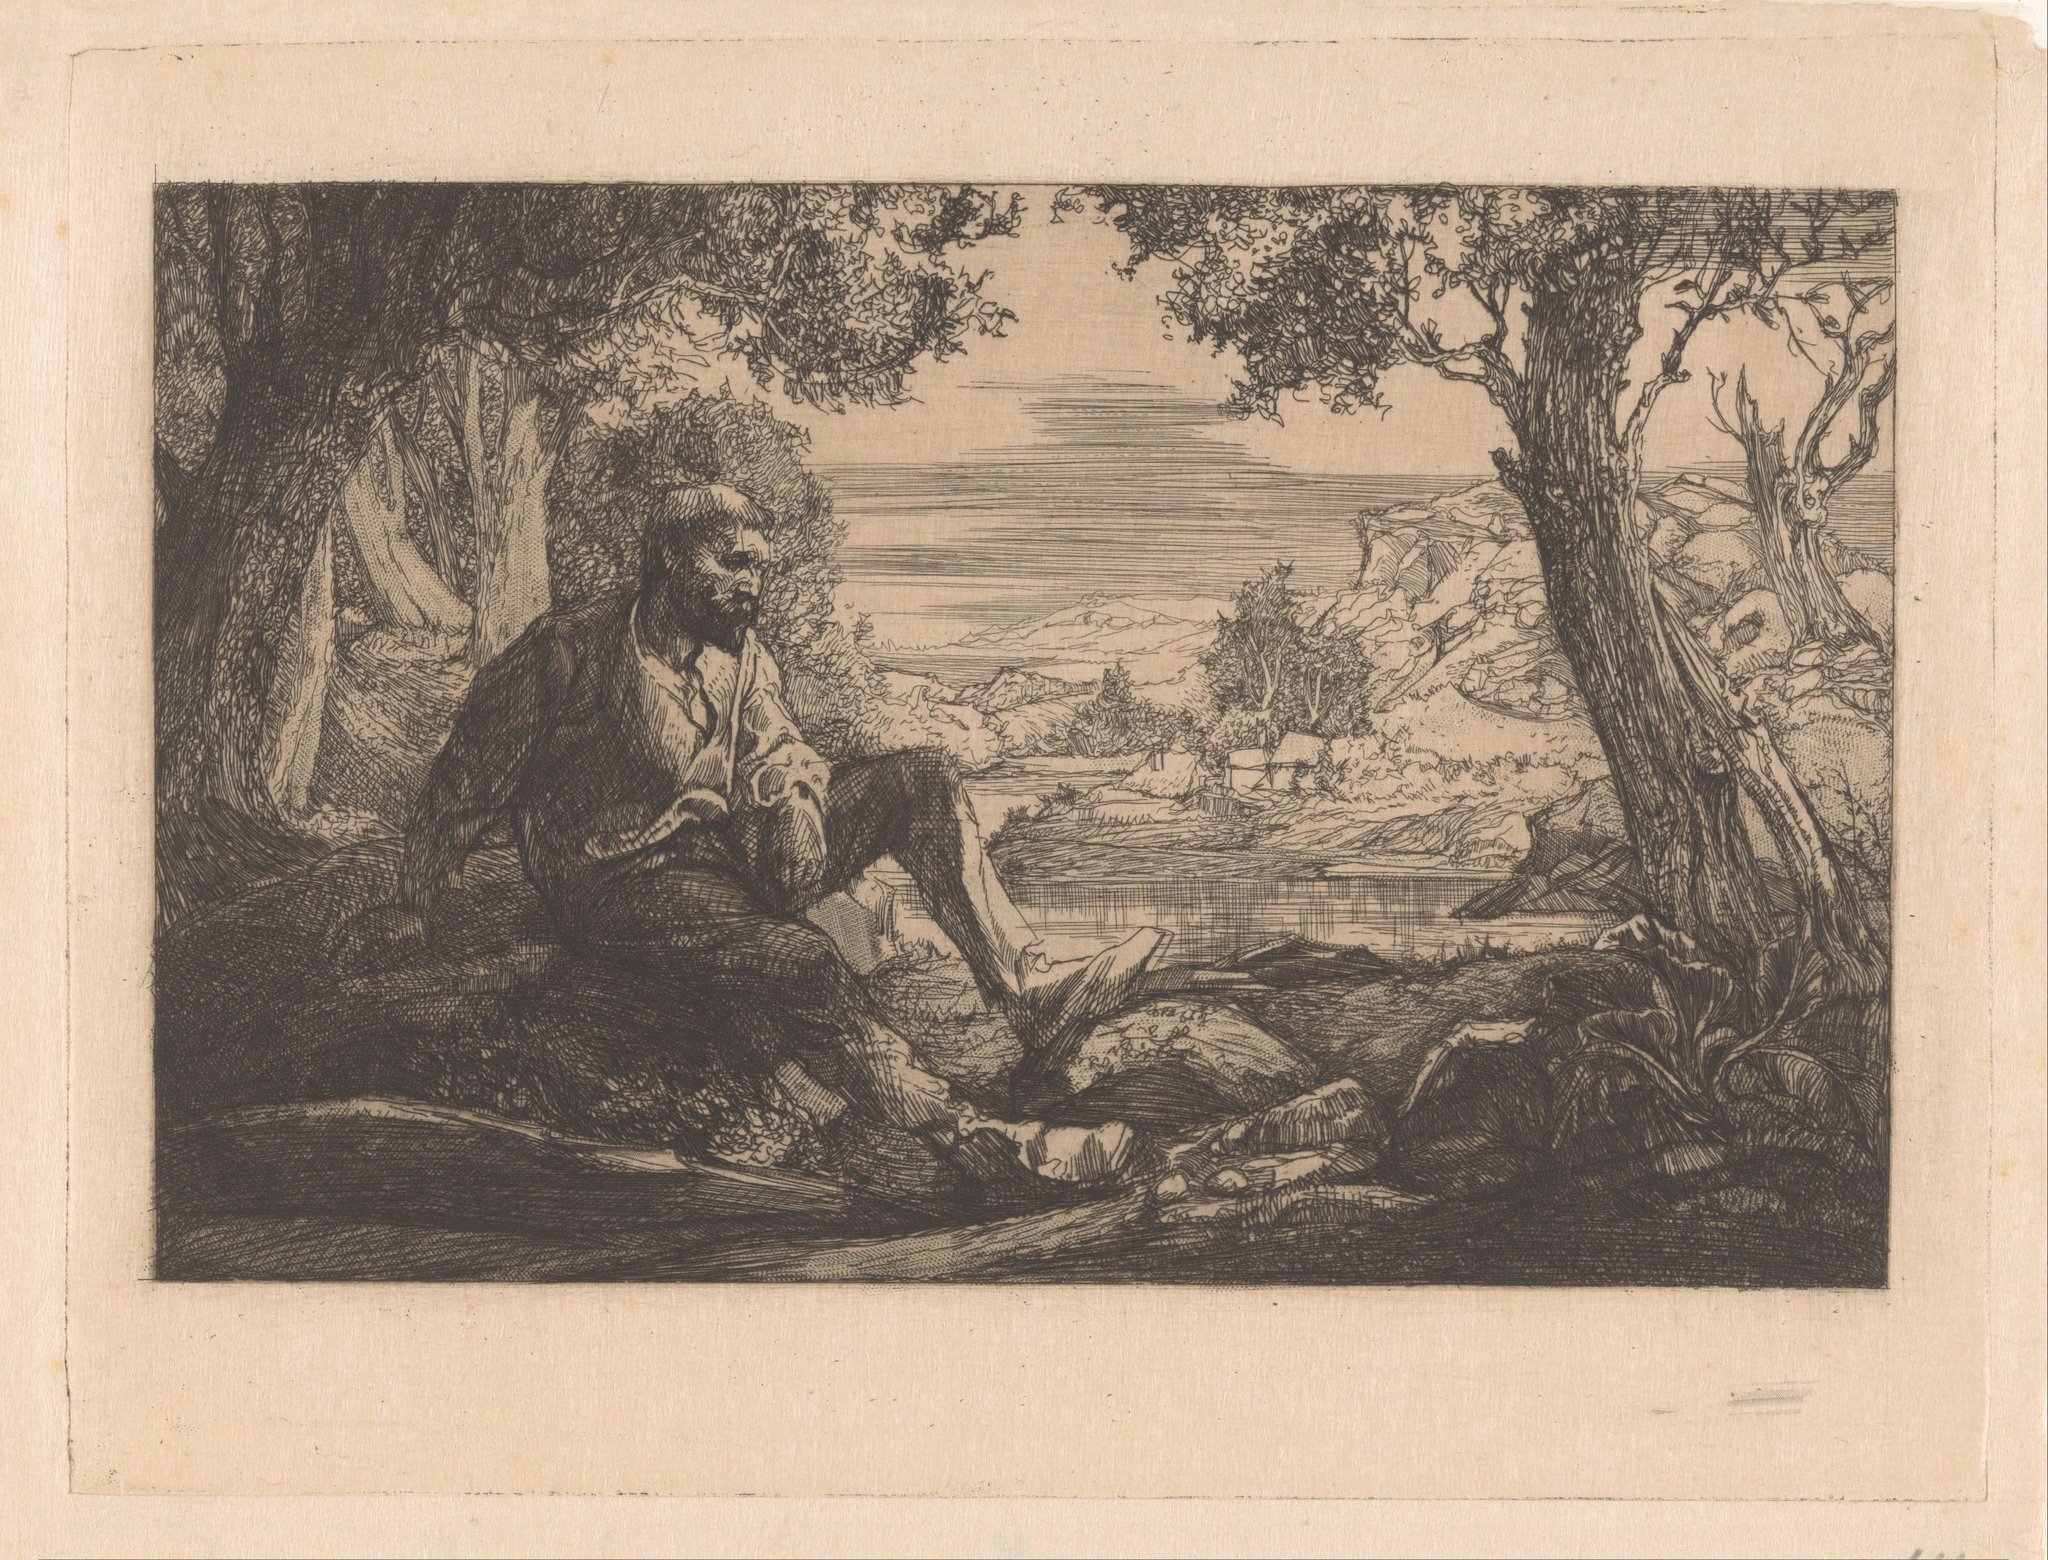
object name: print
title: Landloper in landschap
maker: johannes josephus aarts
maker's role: draughtsman, print maker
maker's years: 1871-1934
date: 1881-1934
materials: paper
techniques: etching, intaglio, roulette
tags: river - hh - ideal landscapes, low hill country, sitting figure (+ sideview, profile), beard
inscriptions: collector's mark: Lugt 2228, collector's mark: Lugt 2760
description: Een bebaarde man zit op een rots in een met bomen begroeid heuvellandschap. Op de achtergrond zijn een meanderende rivier en bebouwing zichtbaar.